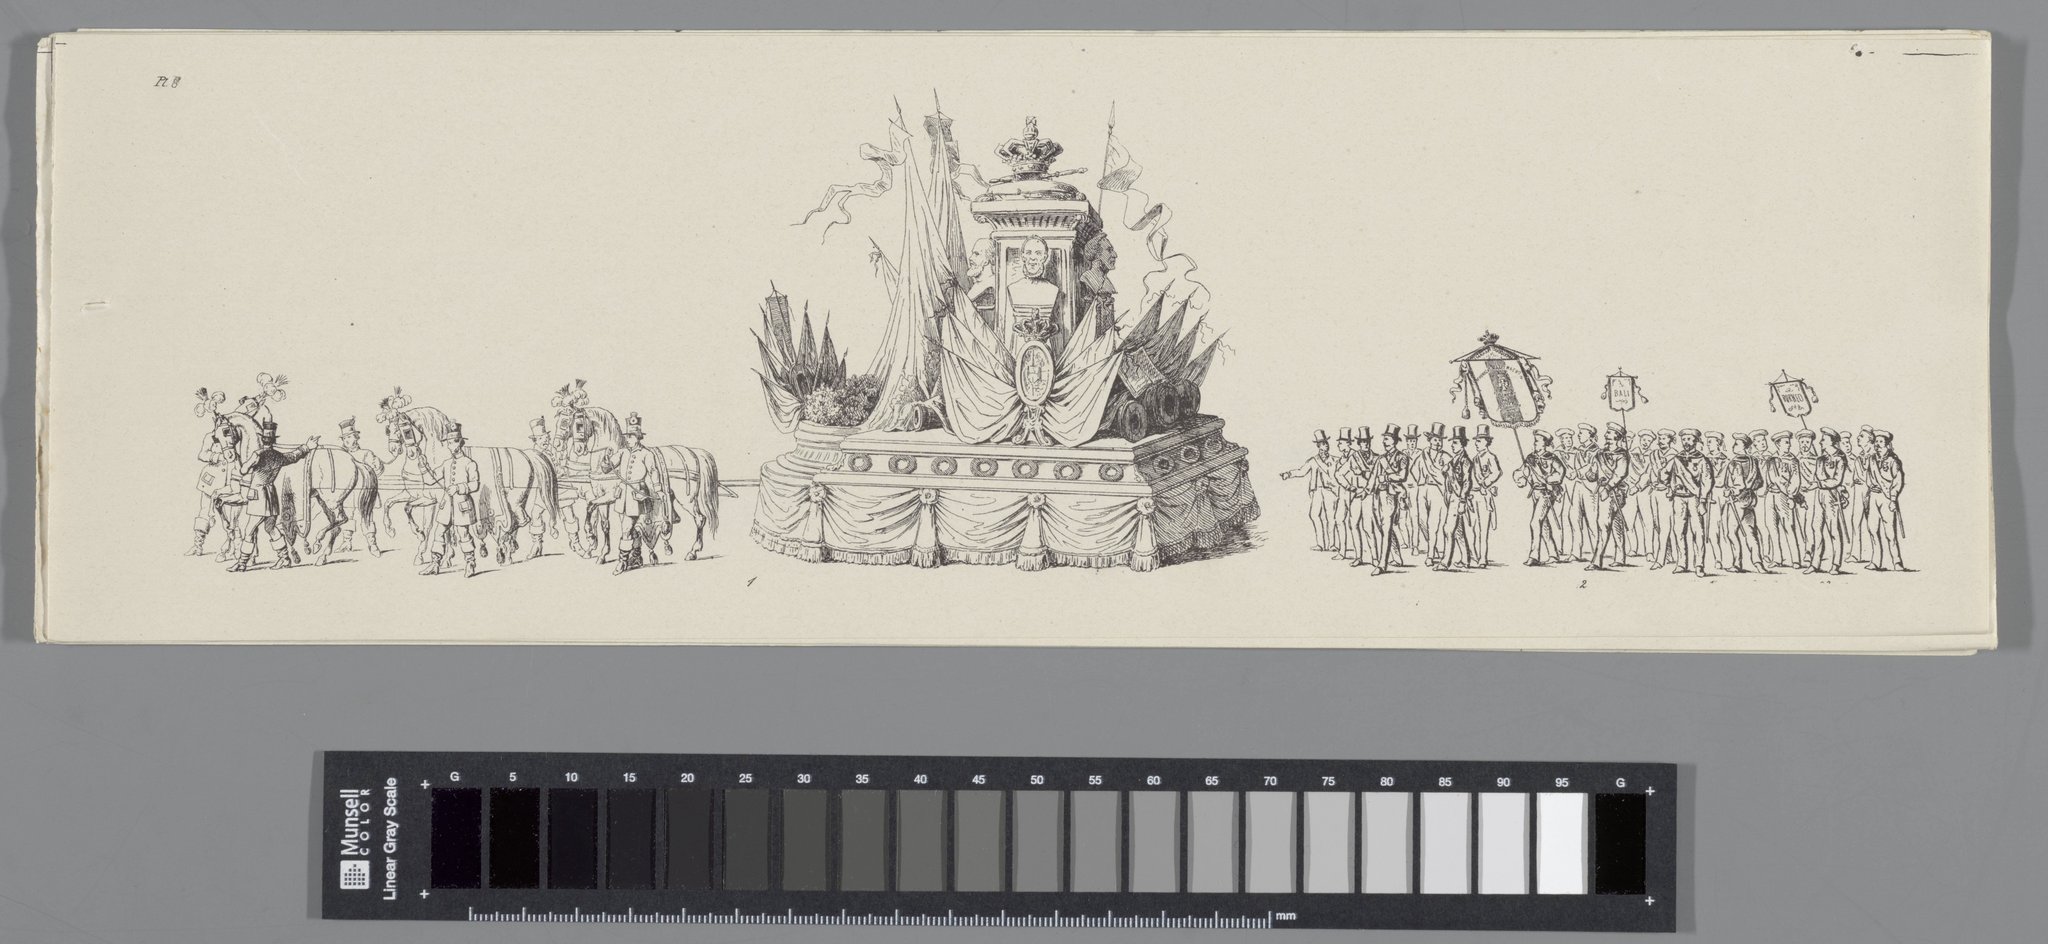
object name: print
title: Historische gekostumeerde optocht te Amsterdam bij het 25-jarige regeringsjubileum van koning Willem III in 1874 (plaat 8)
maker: Anonymous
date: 1874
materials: paper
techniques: lithograph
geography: amsterdam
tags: brussels, willem iii (koning der nederlanden), public festivities at other royal events, not meant or mentioned above (+ parade, pageant, cavalcade ~ festive activities), public festivities at other royal events, not meant or mentioned above (+ decorated float, wagon ~ festive activities), amsterdam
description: Plaat nr. 8 met het deel van de optocht met de door zes paarden getrokken Koningswagen, een praalwagen met een monument met bustes van de eerste drie Nederlandse koningen. Daarachter het bestuur van de 'Vereeniging van het Indische Kruis'. Onderdeel van een serie van 24 platen van de gekostumeerde historische en allegorische optocht gehouden te Amsterdam op 12 mei 1874, als onderdeel van de feestelijkheden tijdens de viering van het 25-jarige regeringsjubileum van koning Willem III.